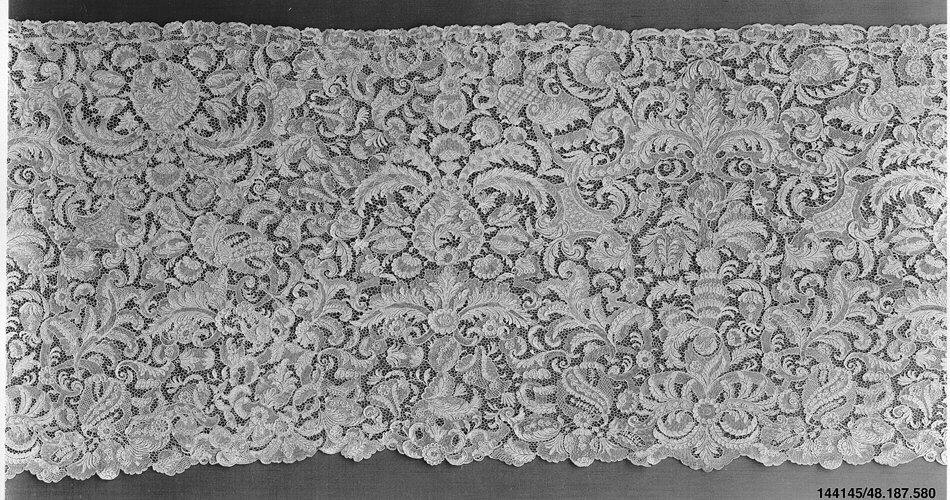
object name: flounce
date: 1701-1800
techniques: lace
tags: flowers